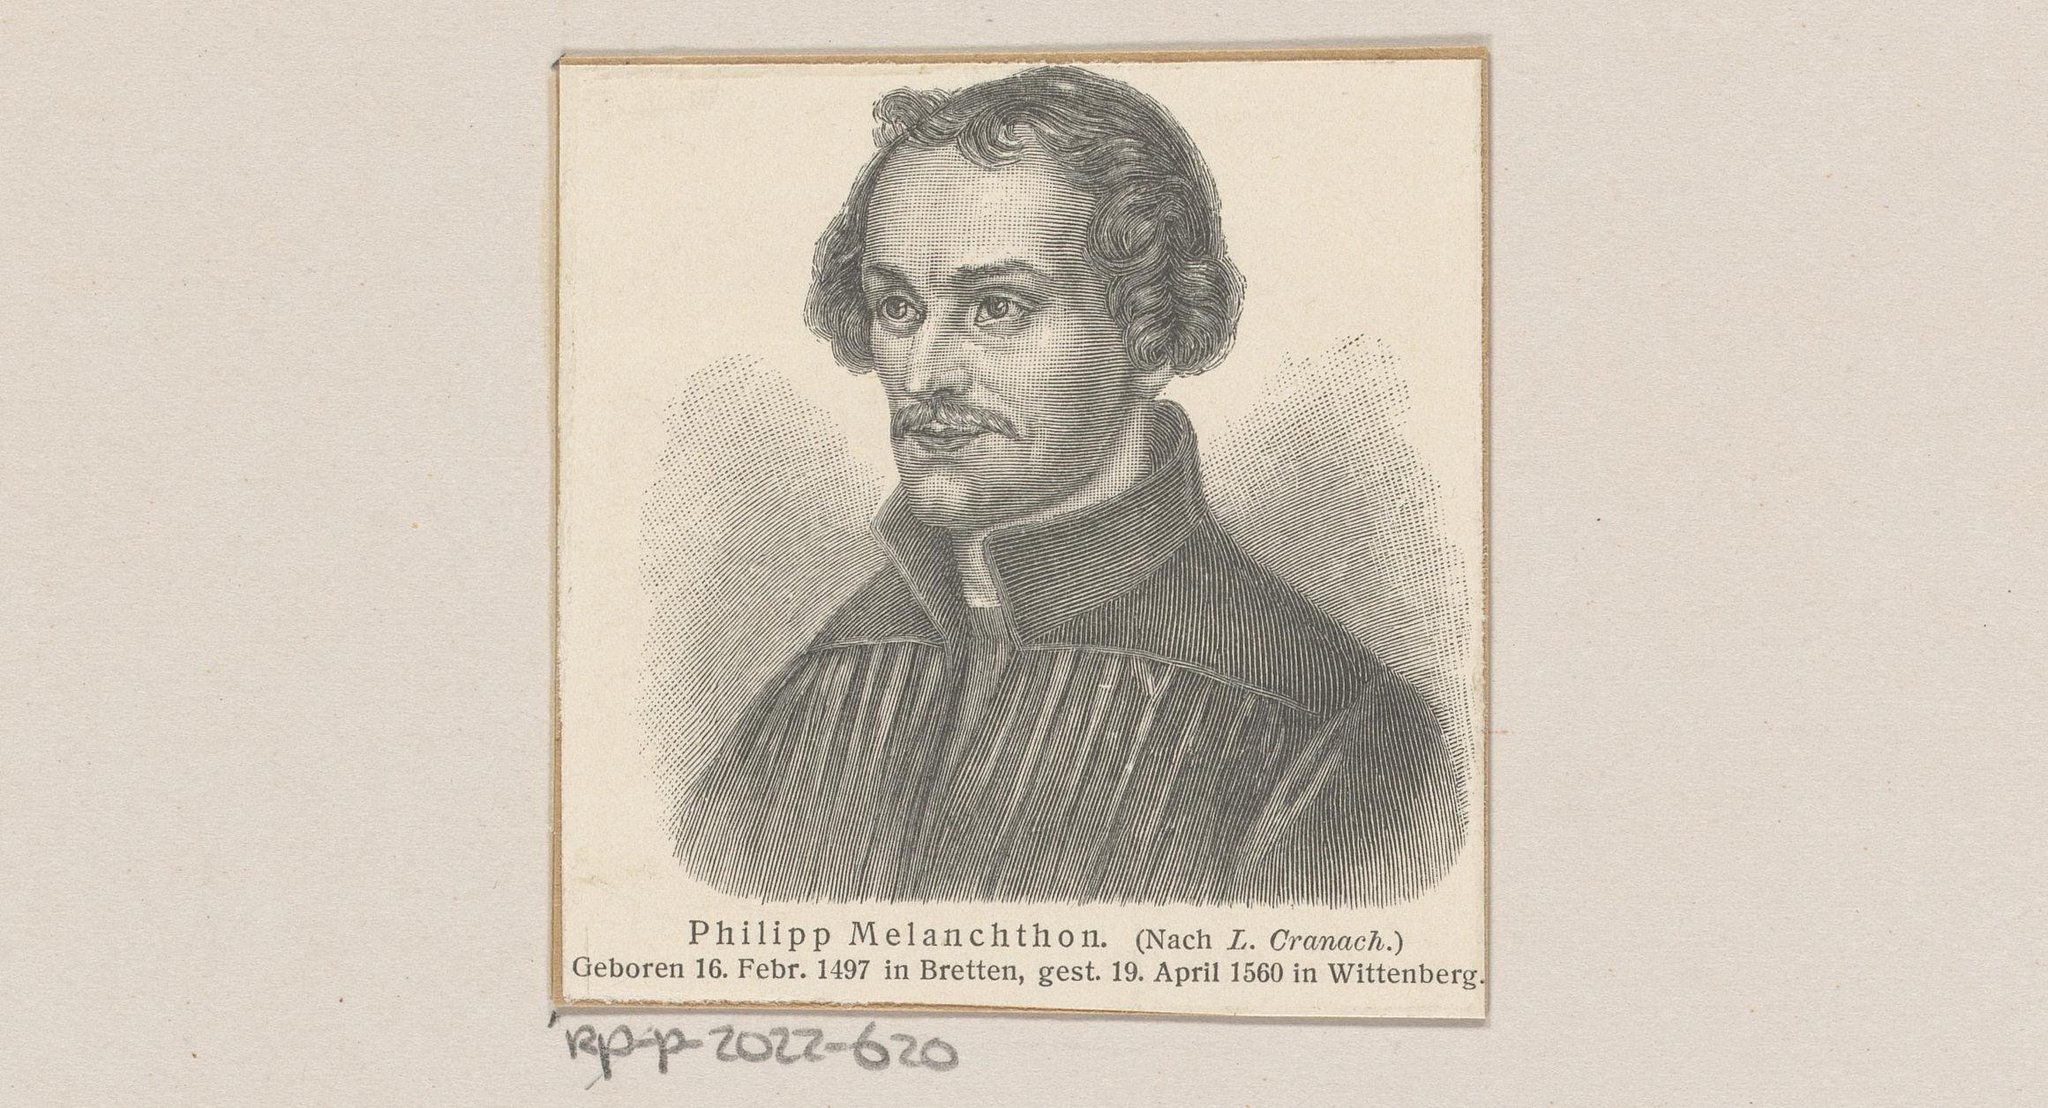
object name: print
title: Portret van Philipp Melanchthon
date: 1750-1900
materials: paper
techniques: engraving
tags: theologian, historical persons